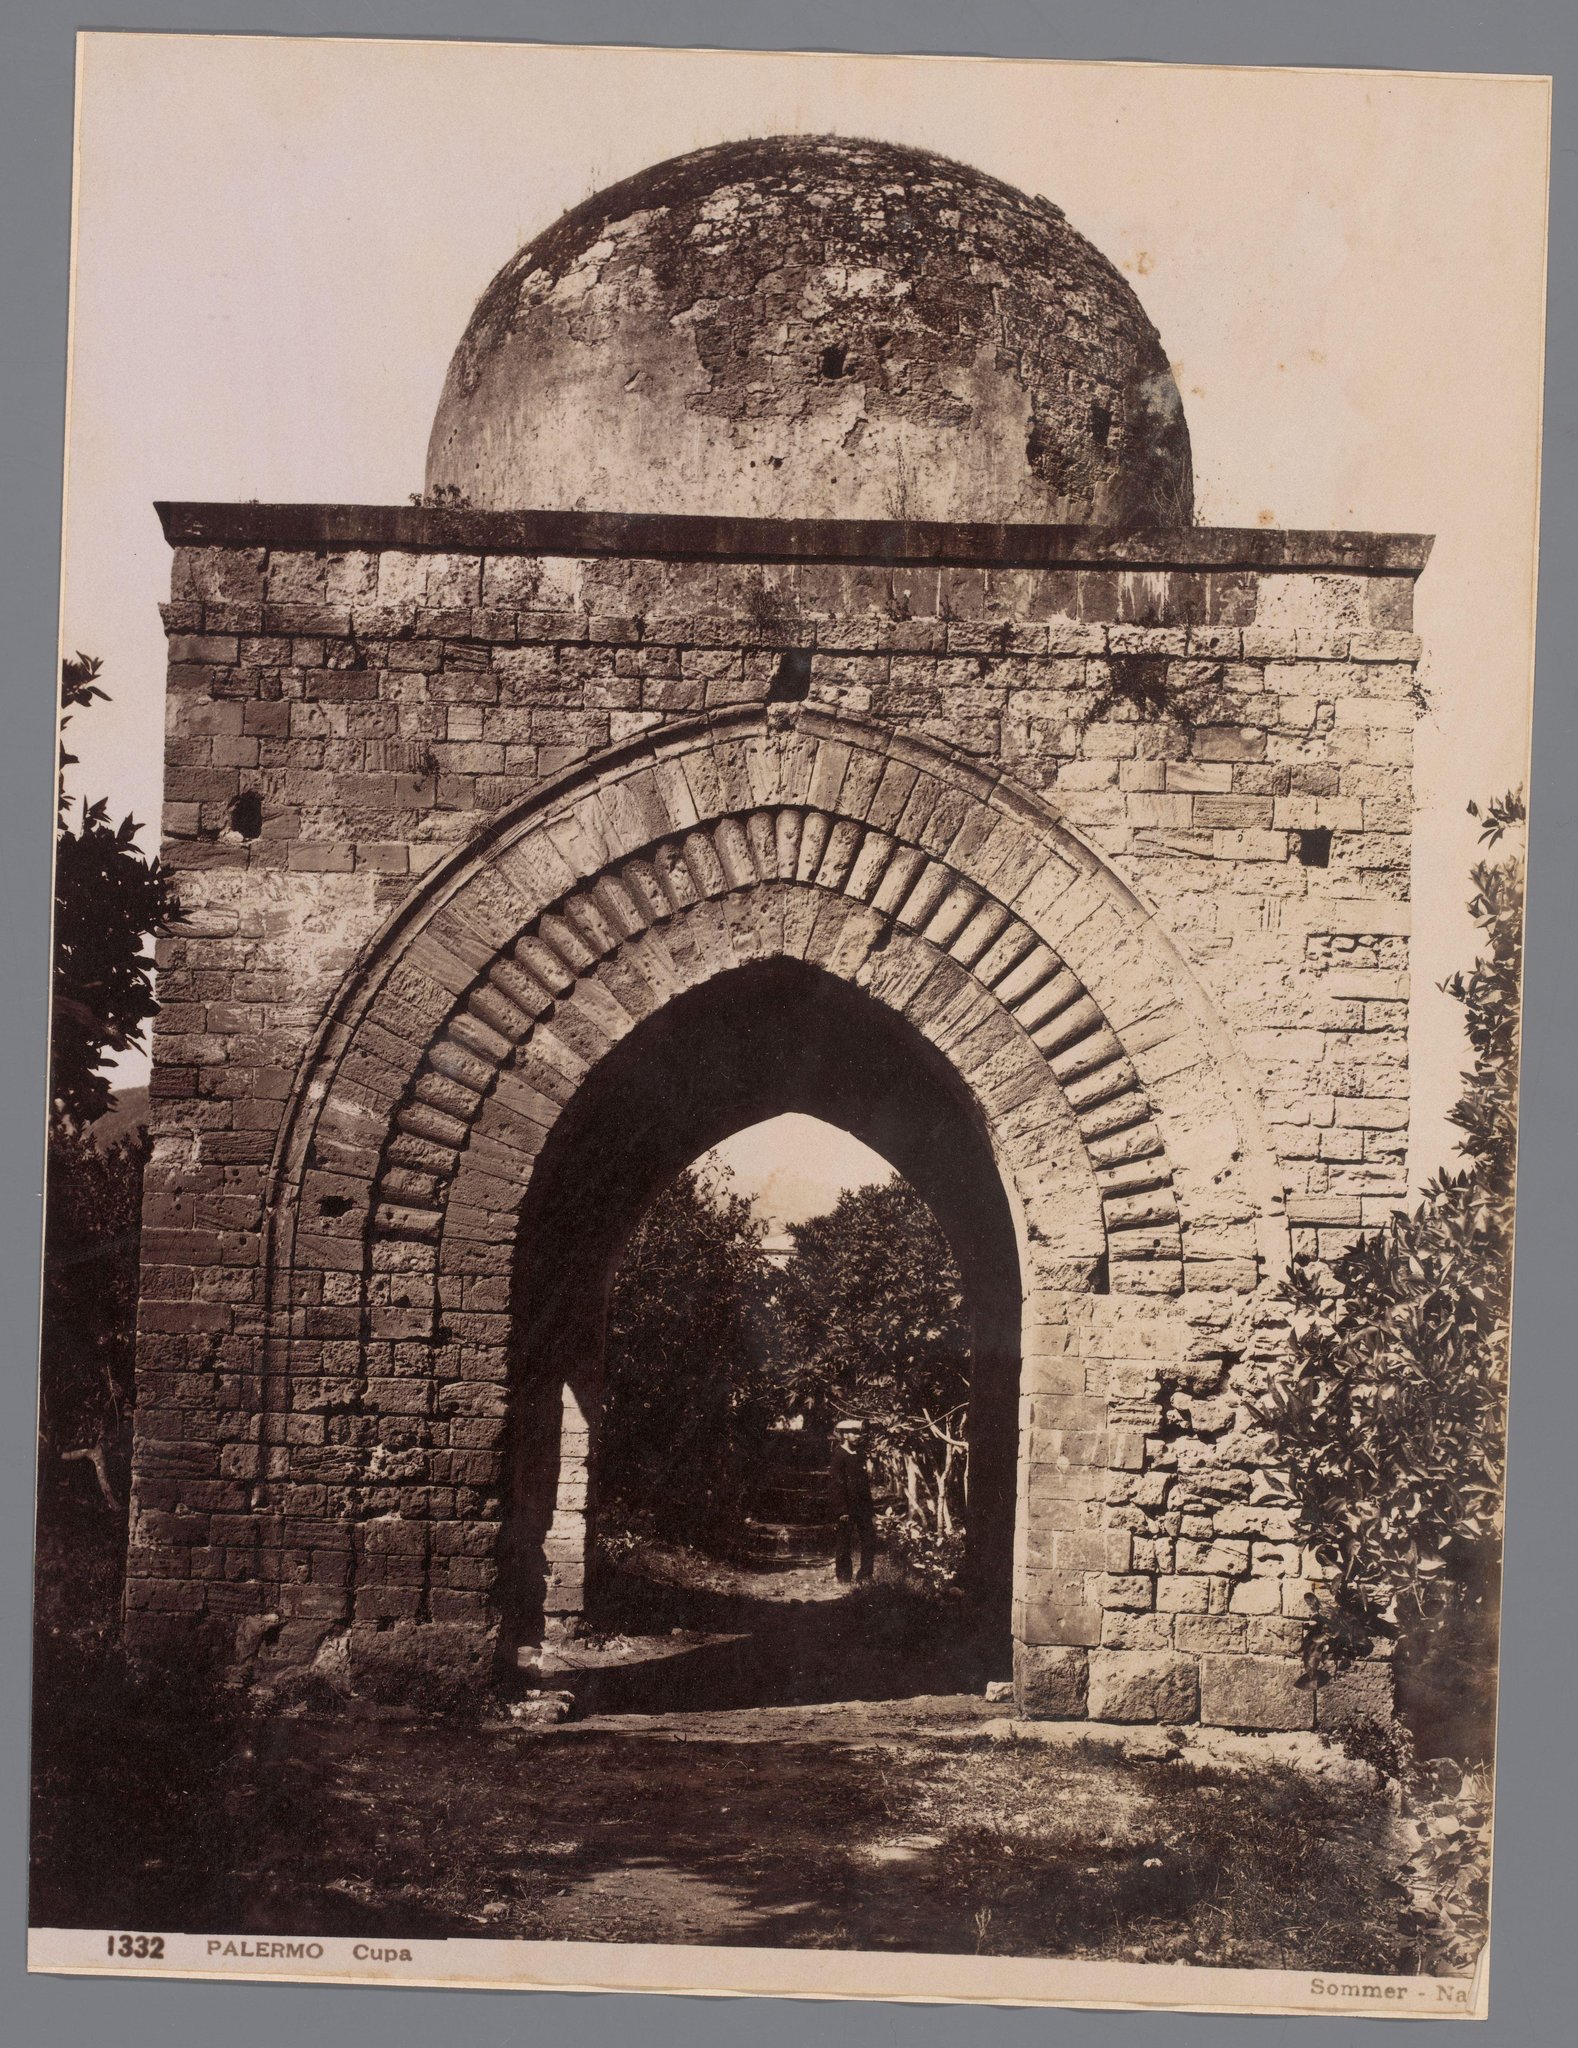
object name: photograph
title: Landschap op Capri, Italië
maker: giorgio sommer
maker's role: fotograaf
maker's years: 1834-1914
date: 1857-1914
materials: cardboard, paper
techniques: albumen print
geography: capri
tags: landscapes, capri, isola di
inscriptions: number: ‘1148’